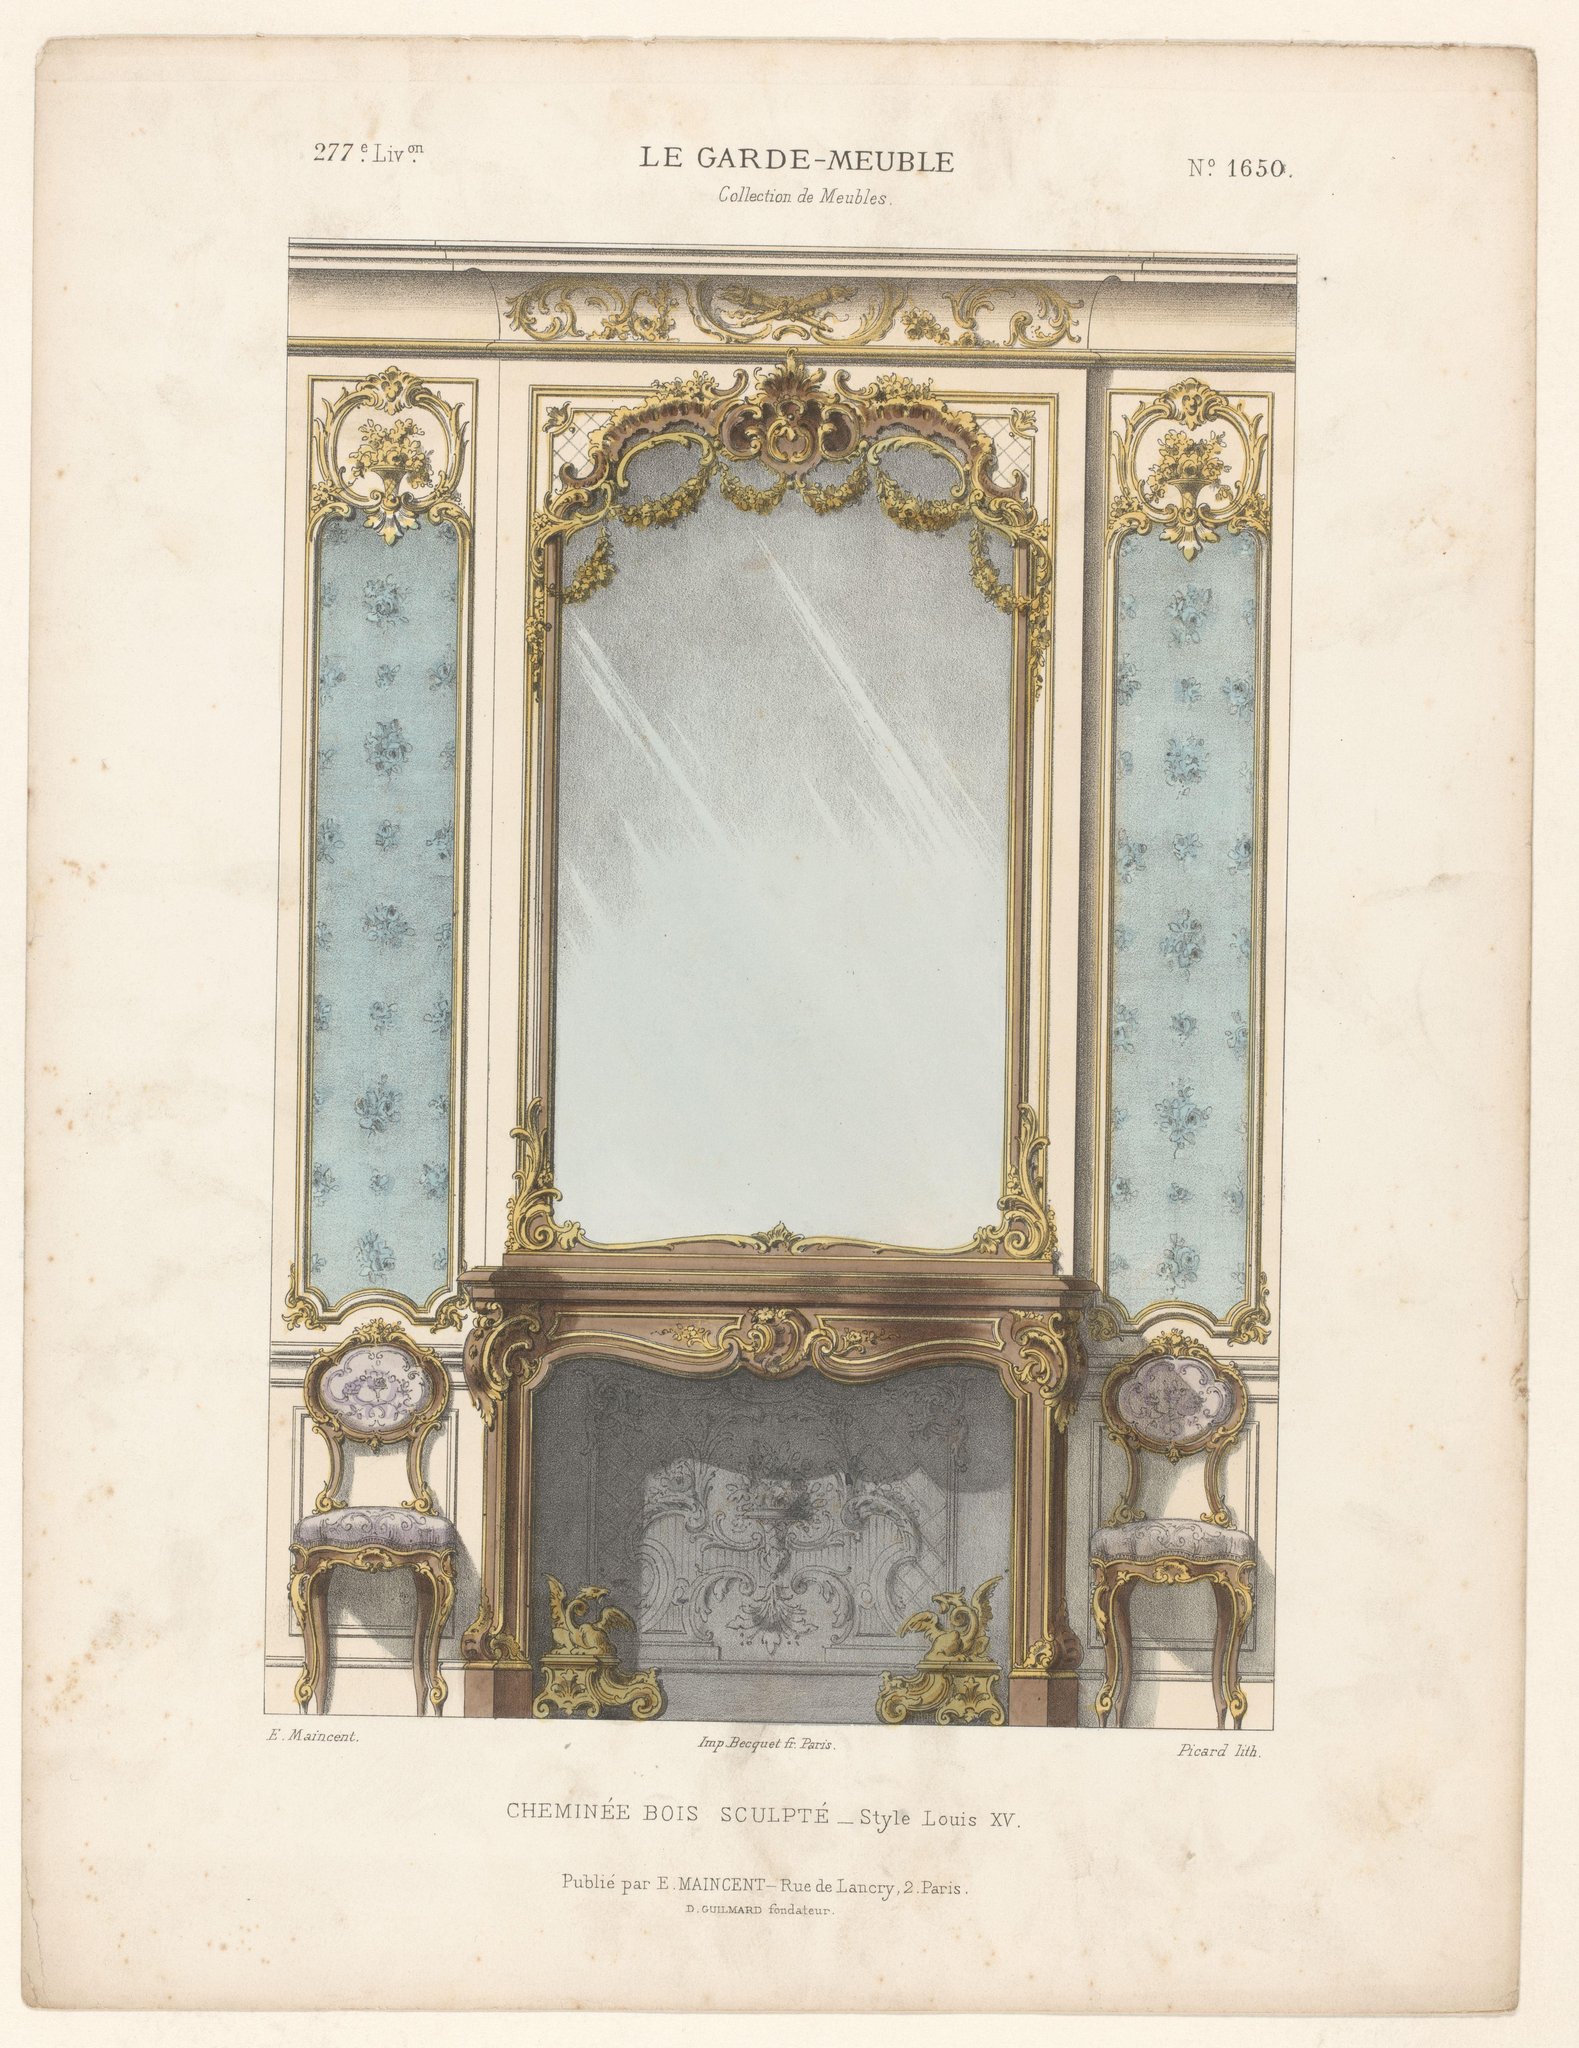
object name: print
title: Schouw met spiegel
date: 1885-1895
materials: paper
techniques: hand coloring, lithograph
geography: paris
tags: chimney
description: Ieder Livraison in de serie Le Garde-Meuble bevat negen platen: drie 'sièges' (zitmeubels), drie 'meubles' (diverse meubels zoals tafels en kasten) en drie 'tentures' (gordijnen en draperieën).